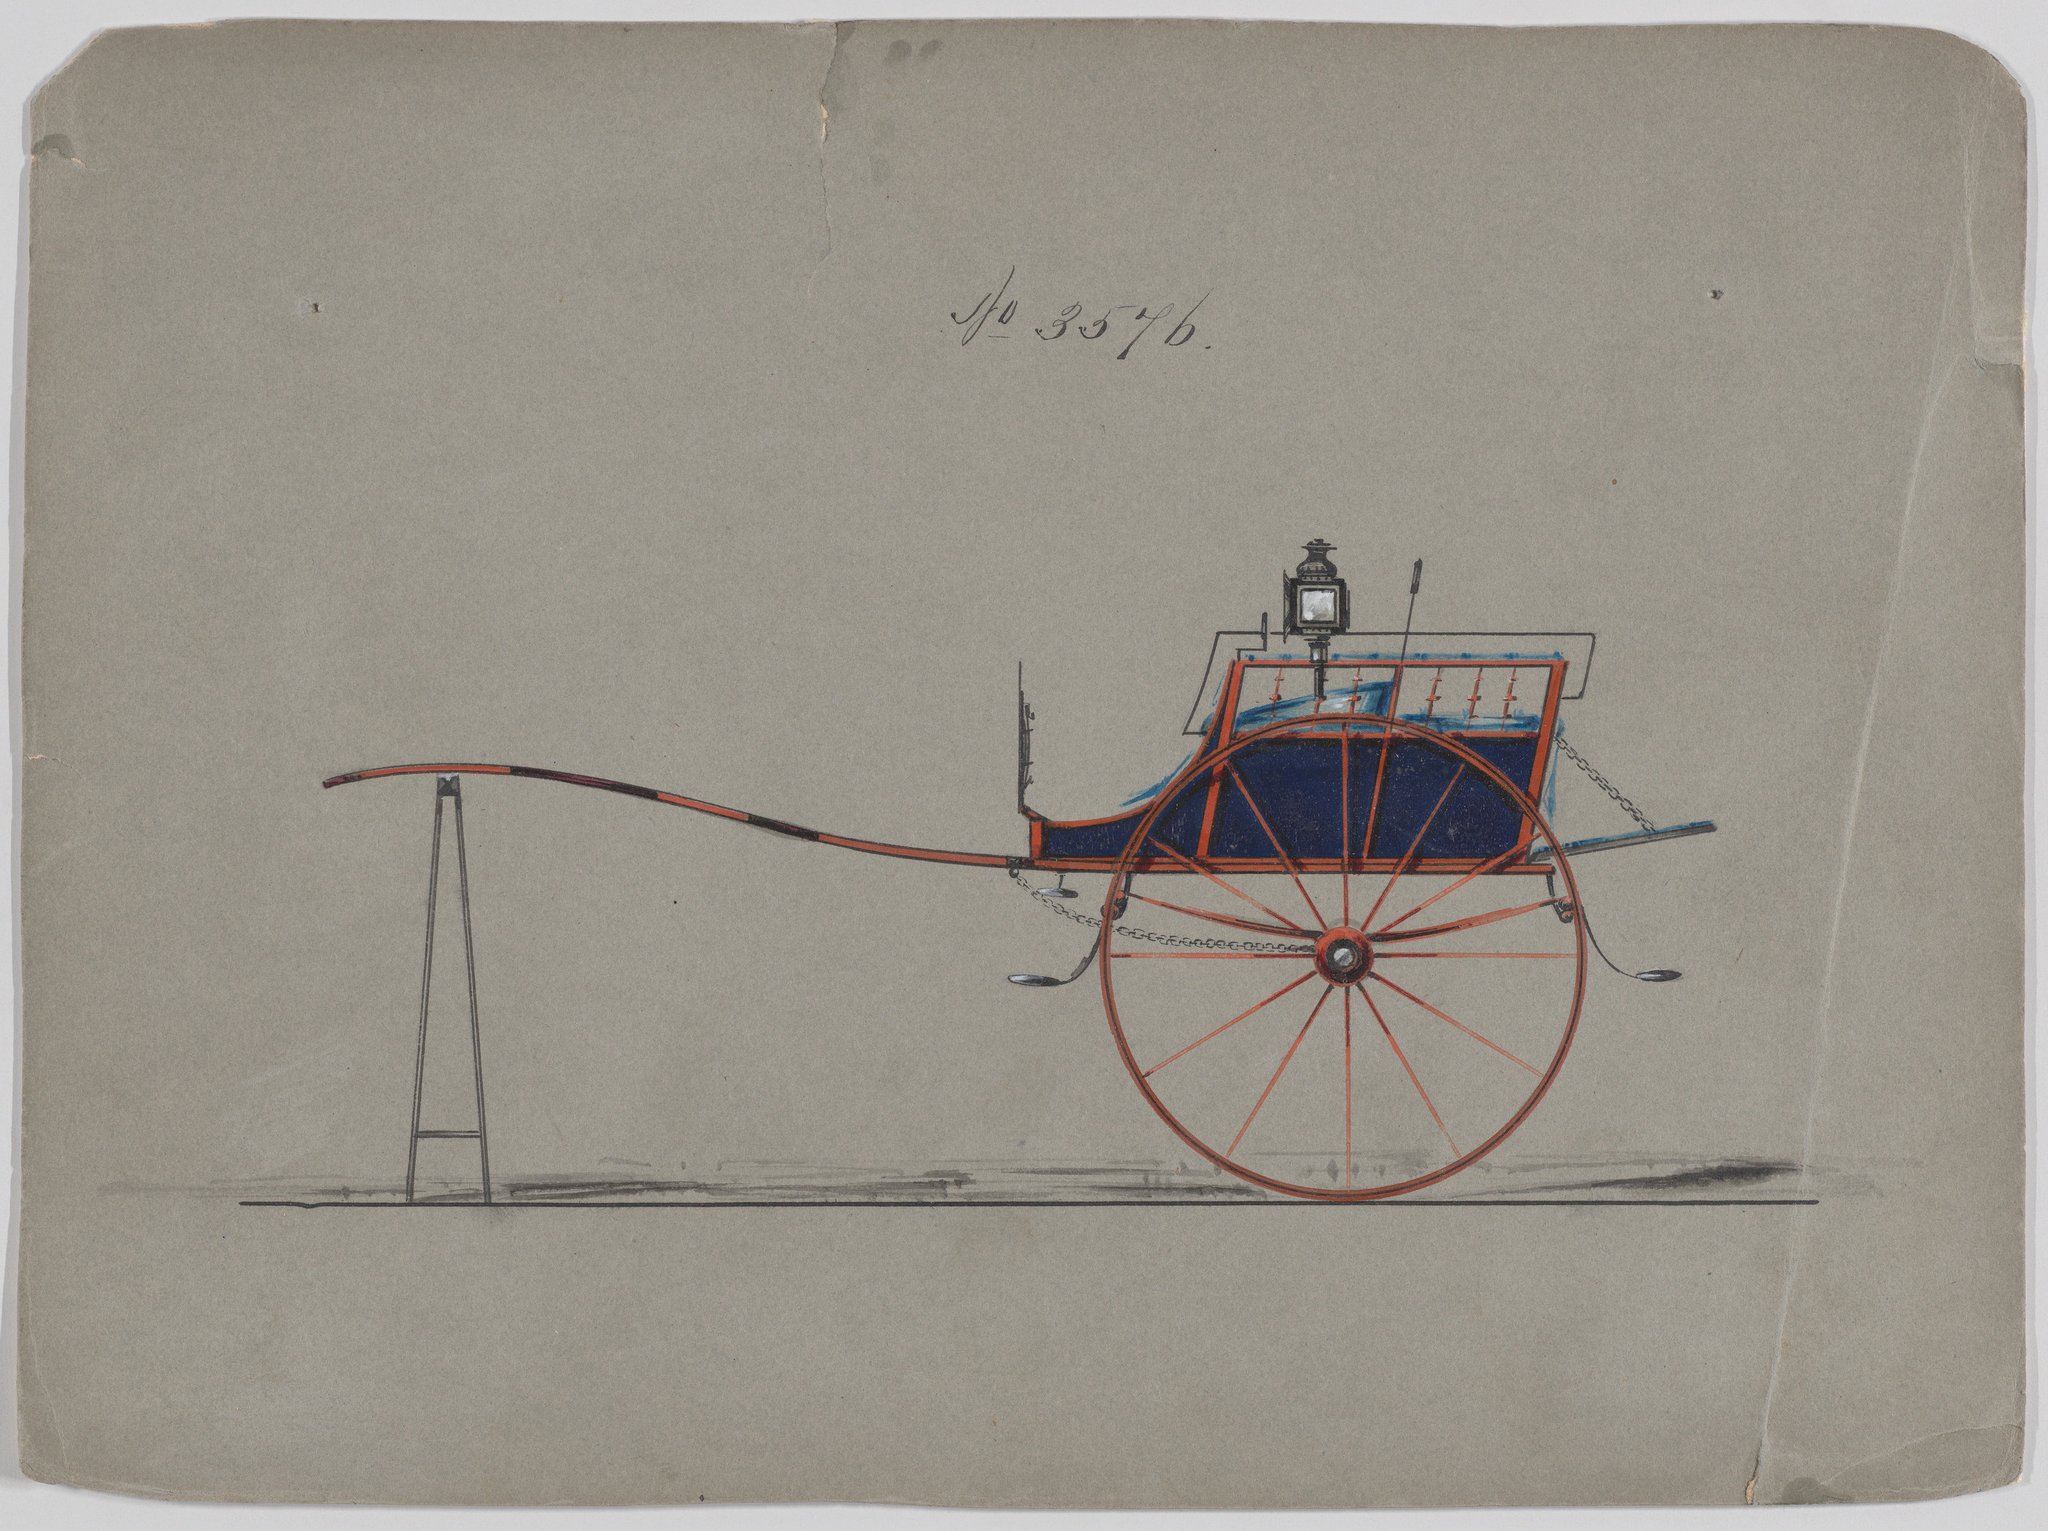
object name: drawing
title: Whitechapel Cart #3576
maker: brewster & co.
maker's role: manufacturer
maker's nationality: american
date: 1880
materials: gouache, gum arabic, watercolor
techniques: pen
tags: carriages